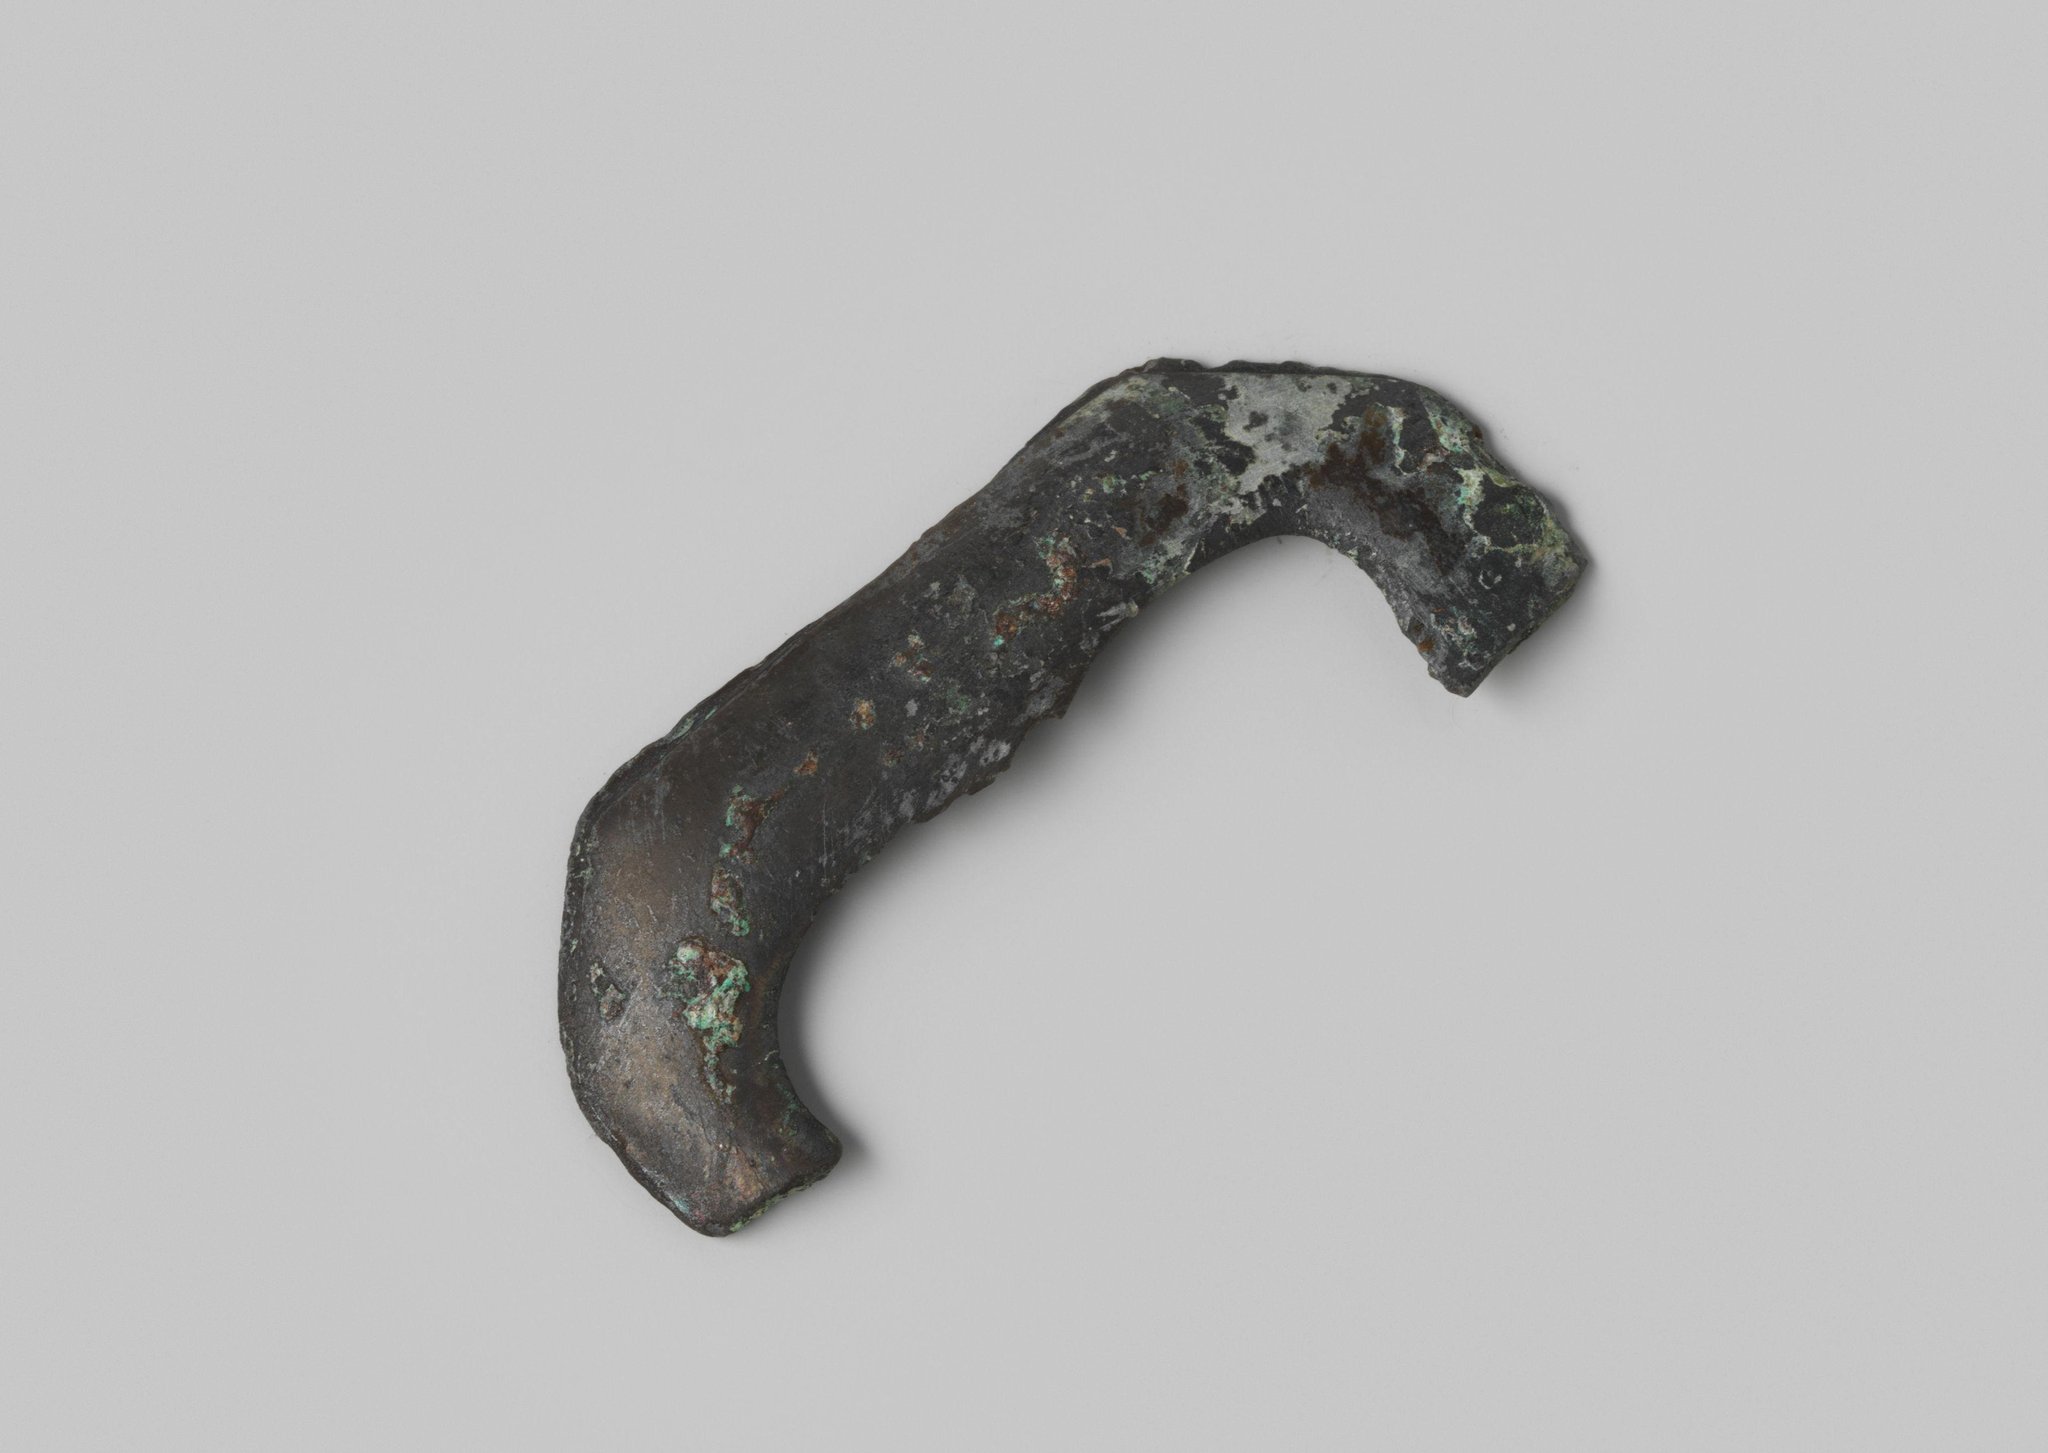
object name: shoe buckle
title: Fragment schoengesp uit het wrak van de Oost-Indiëvaarder Hollandia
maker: Anonymous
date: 1700-1743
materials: silver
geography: netherlands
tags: verenigde oostindische compagnie, hollandia (schip), annet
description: Buckle, chape buckle, shoe buckle; fragment of ring, short side, plain, angular outline.